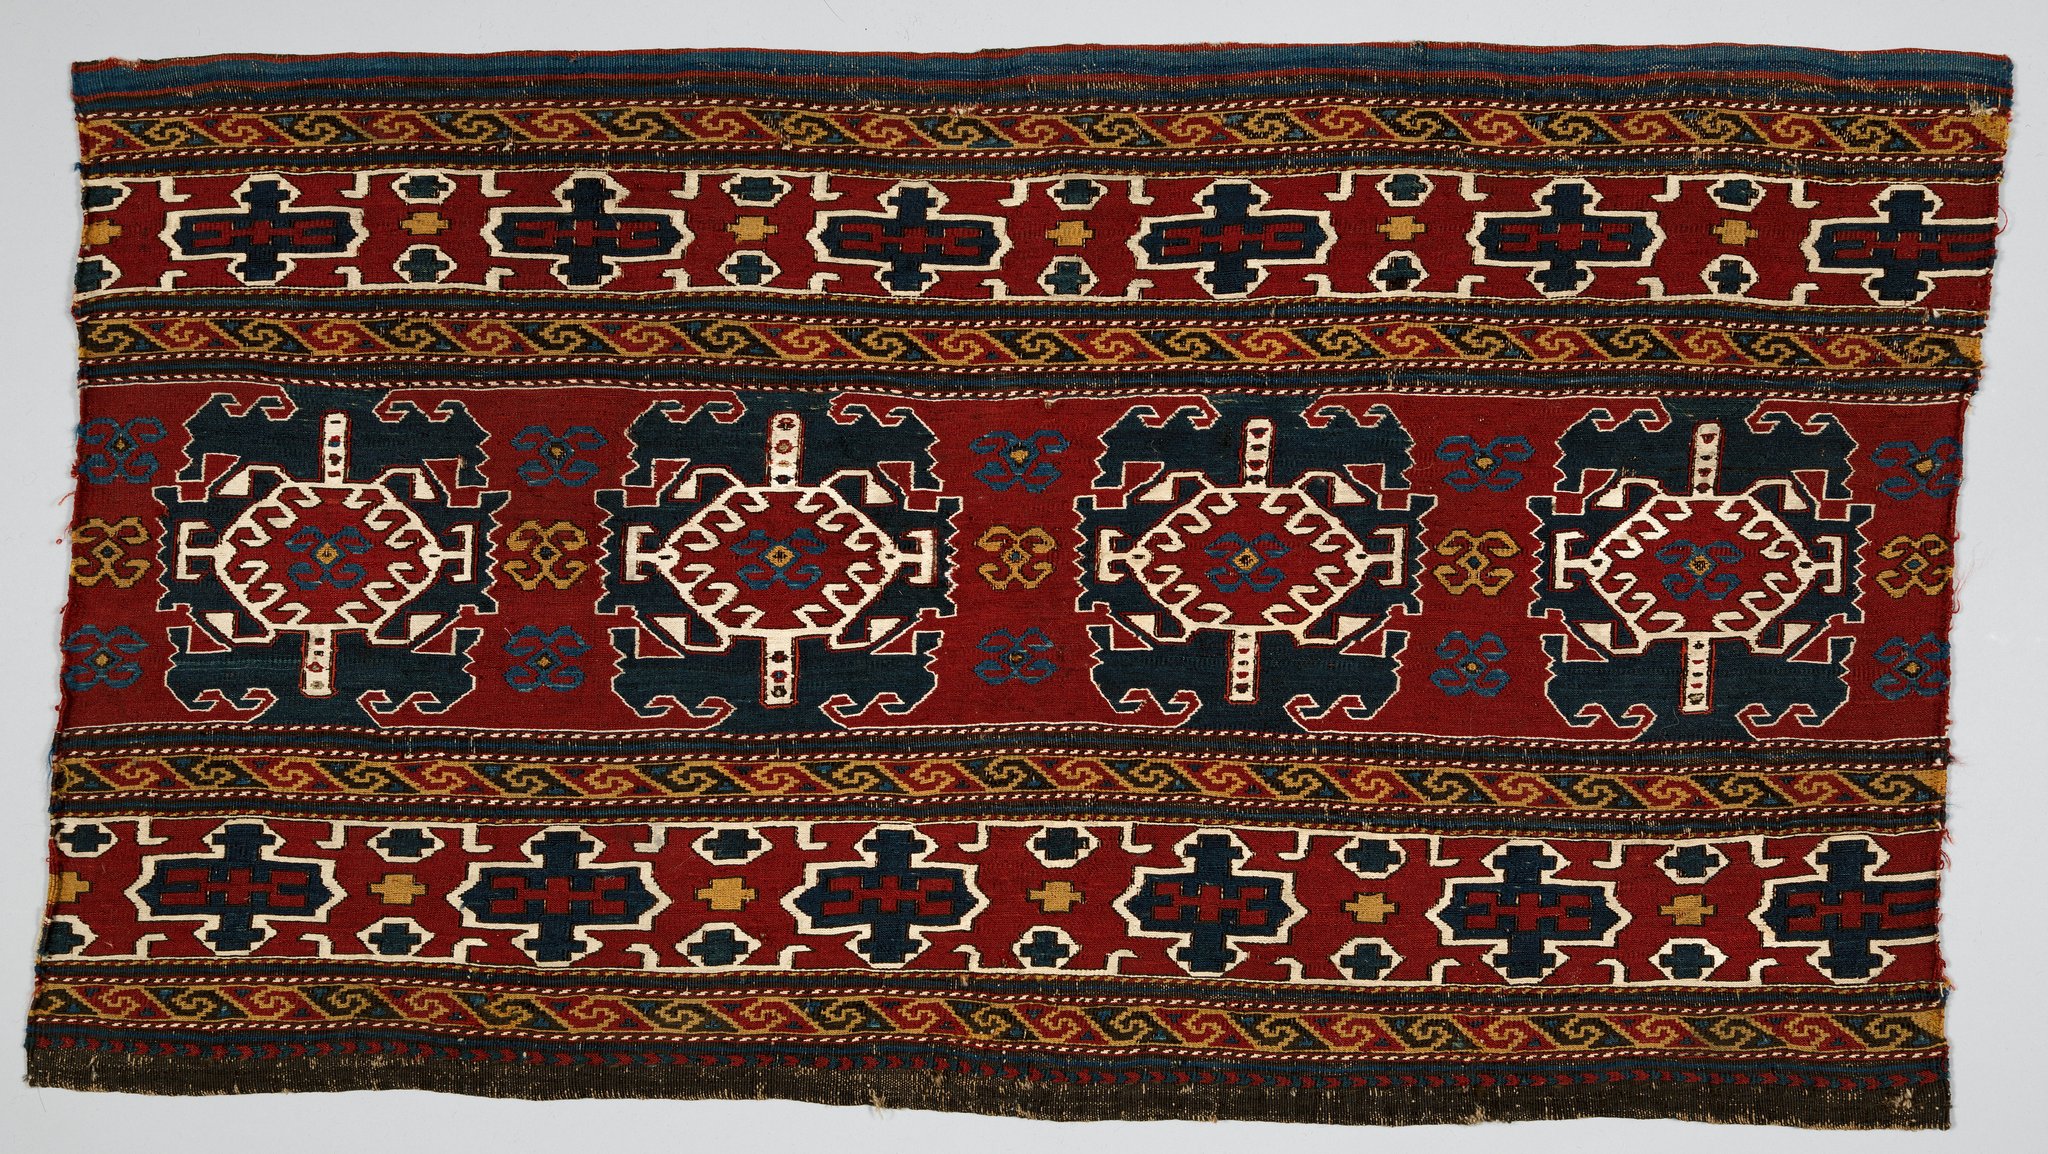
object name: bag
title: Bedding Bag Side Panel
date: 1850-1875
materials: cotton, wool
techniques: brocade, weave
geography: caucasus